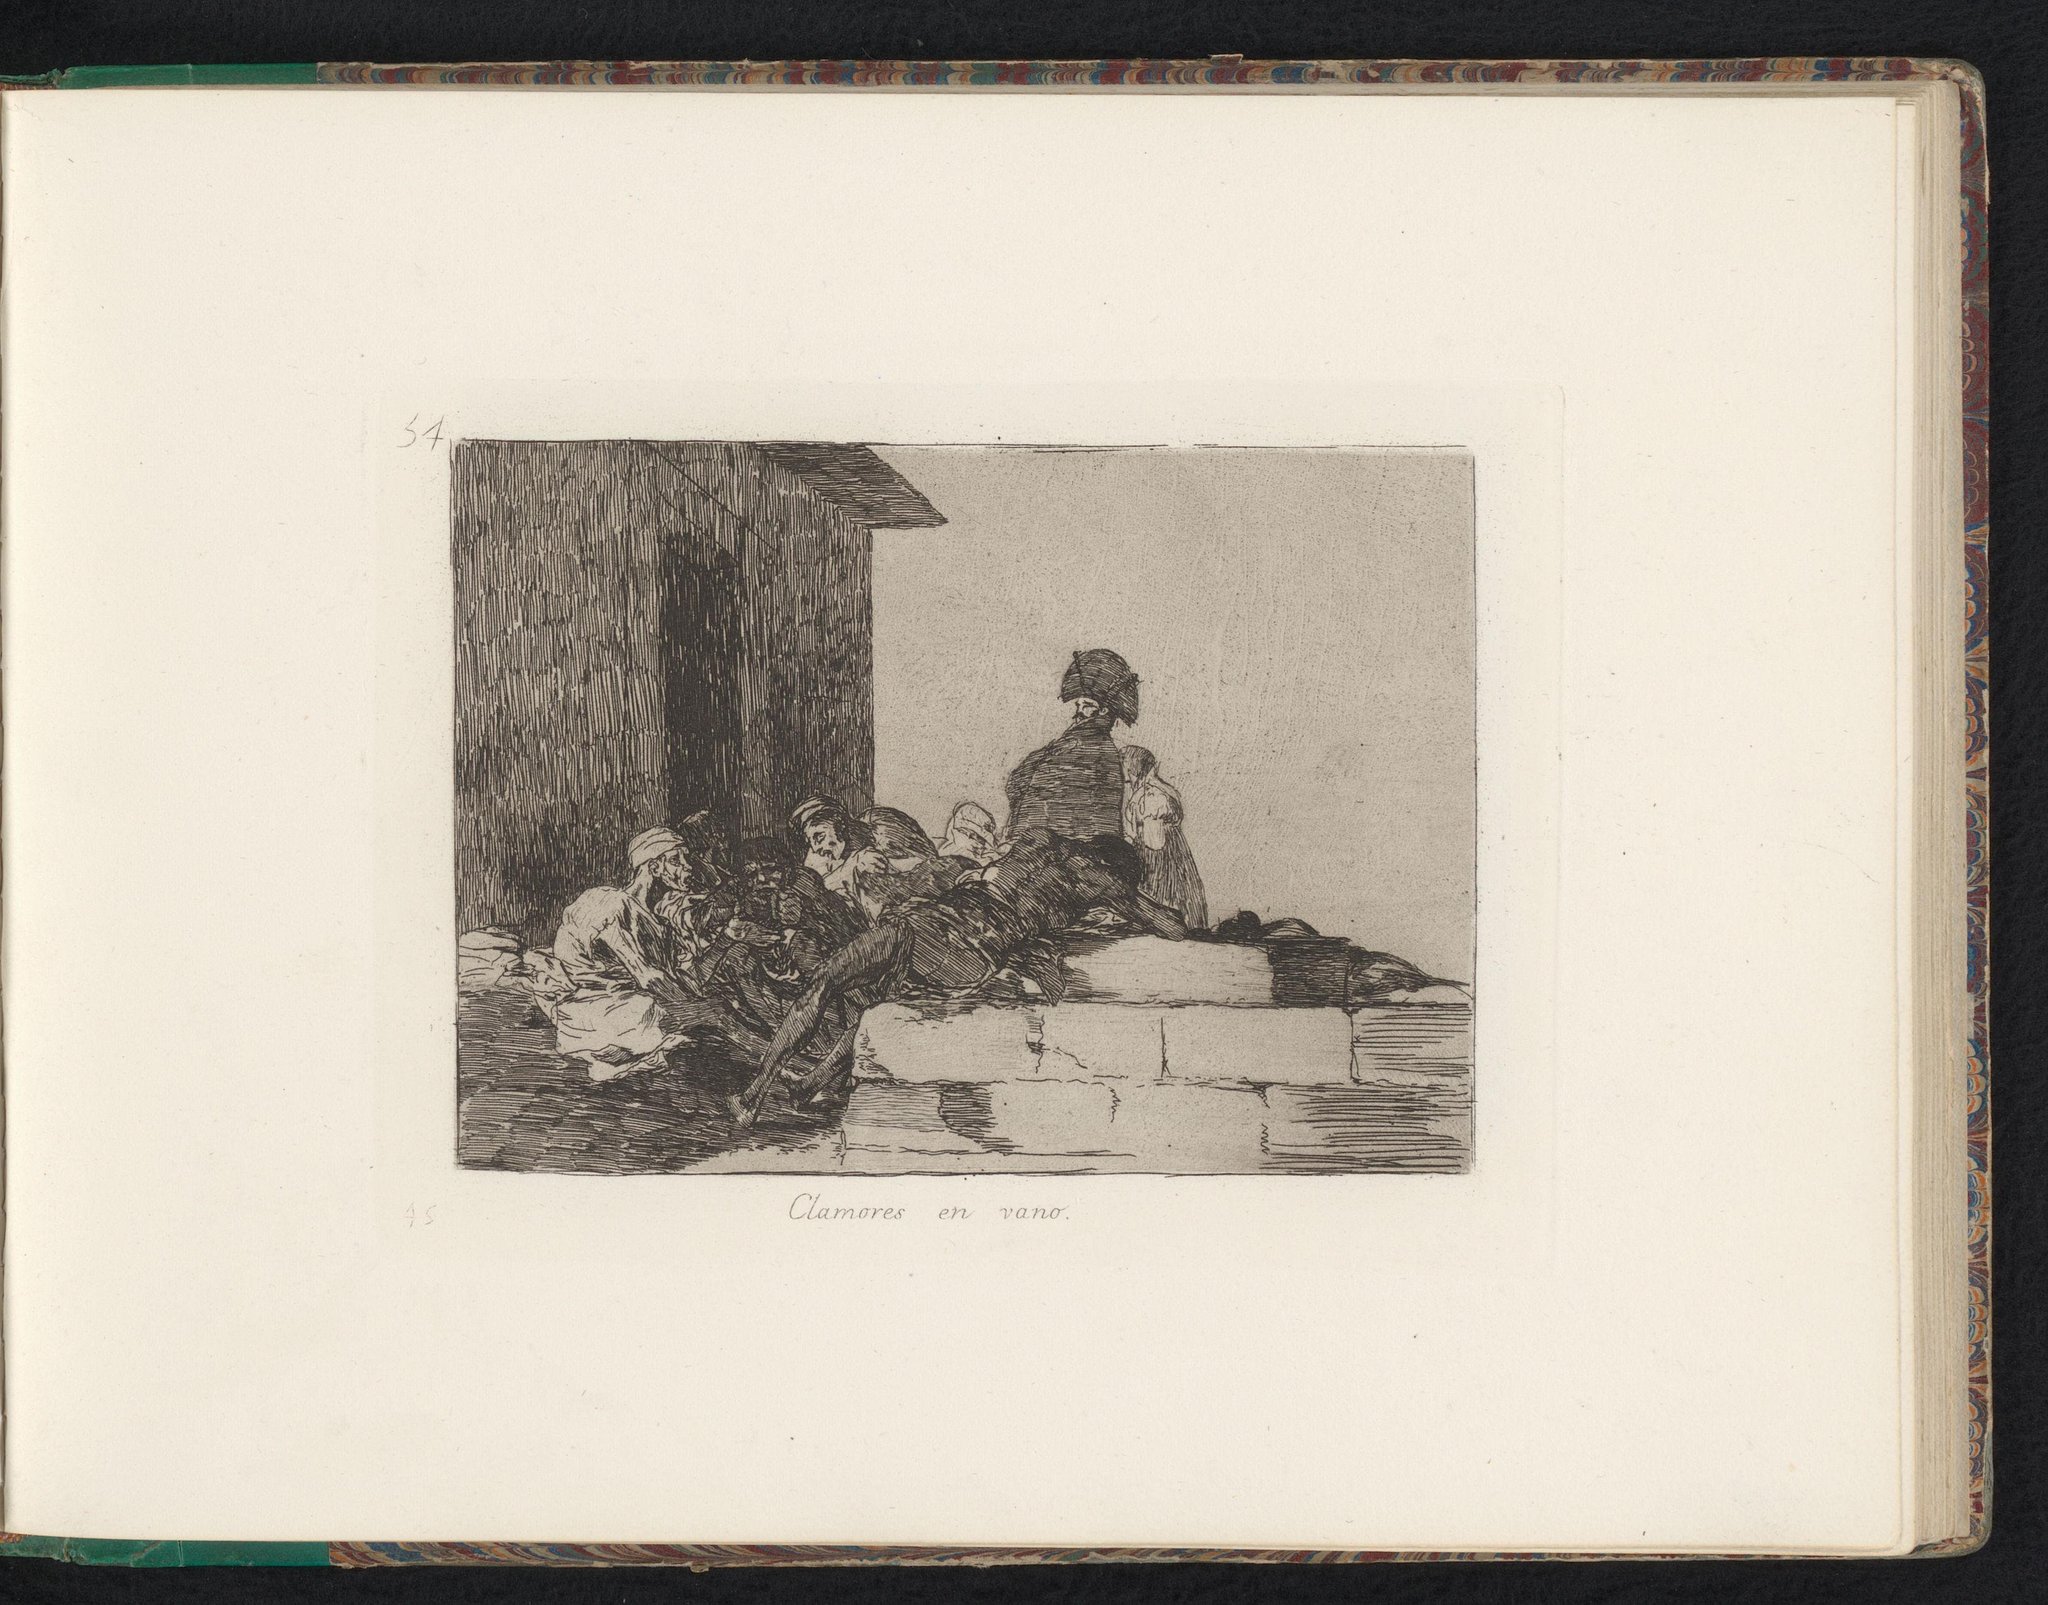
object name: album leaf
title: Los desastres de la guerra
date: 1810-1820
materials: paper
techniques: aquatint, engraving, etching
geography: madrid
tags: appeal, horrors of war, outcasts, pariahs, spain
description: Deze prent maakt deel uit van een album.